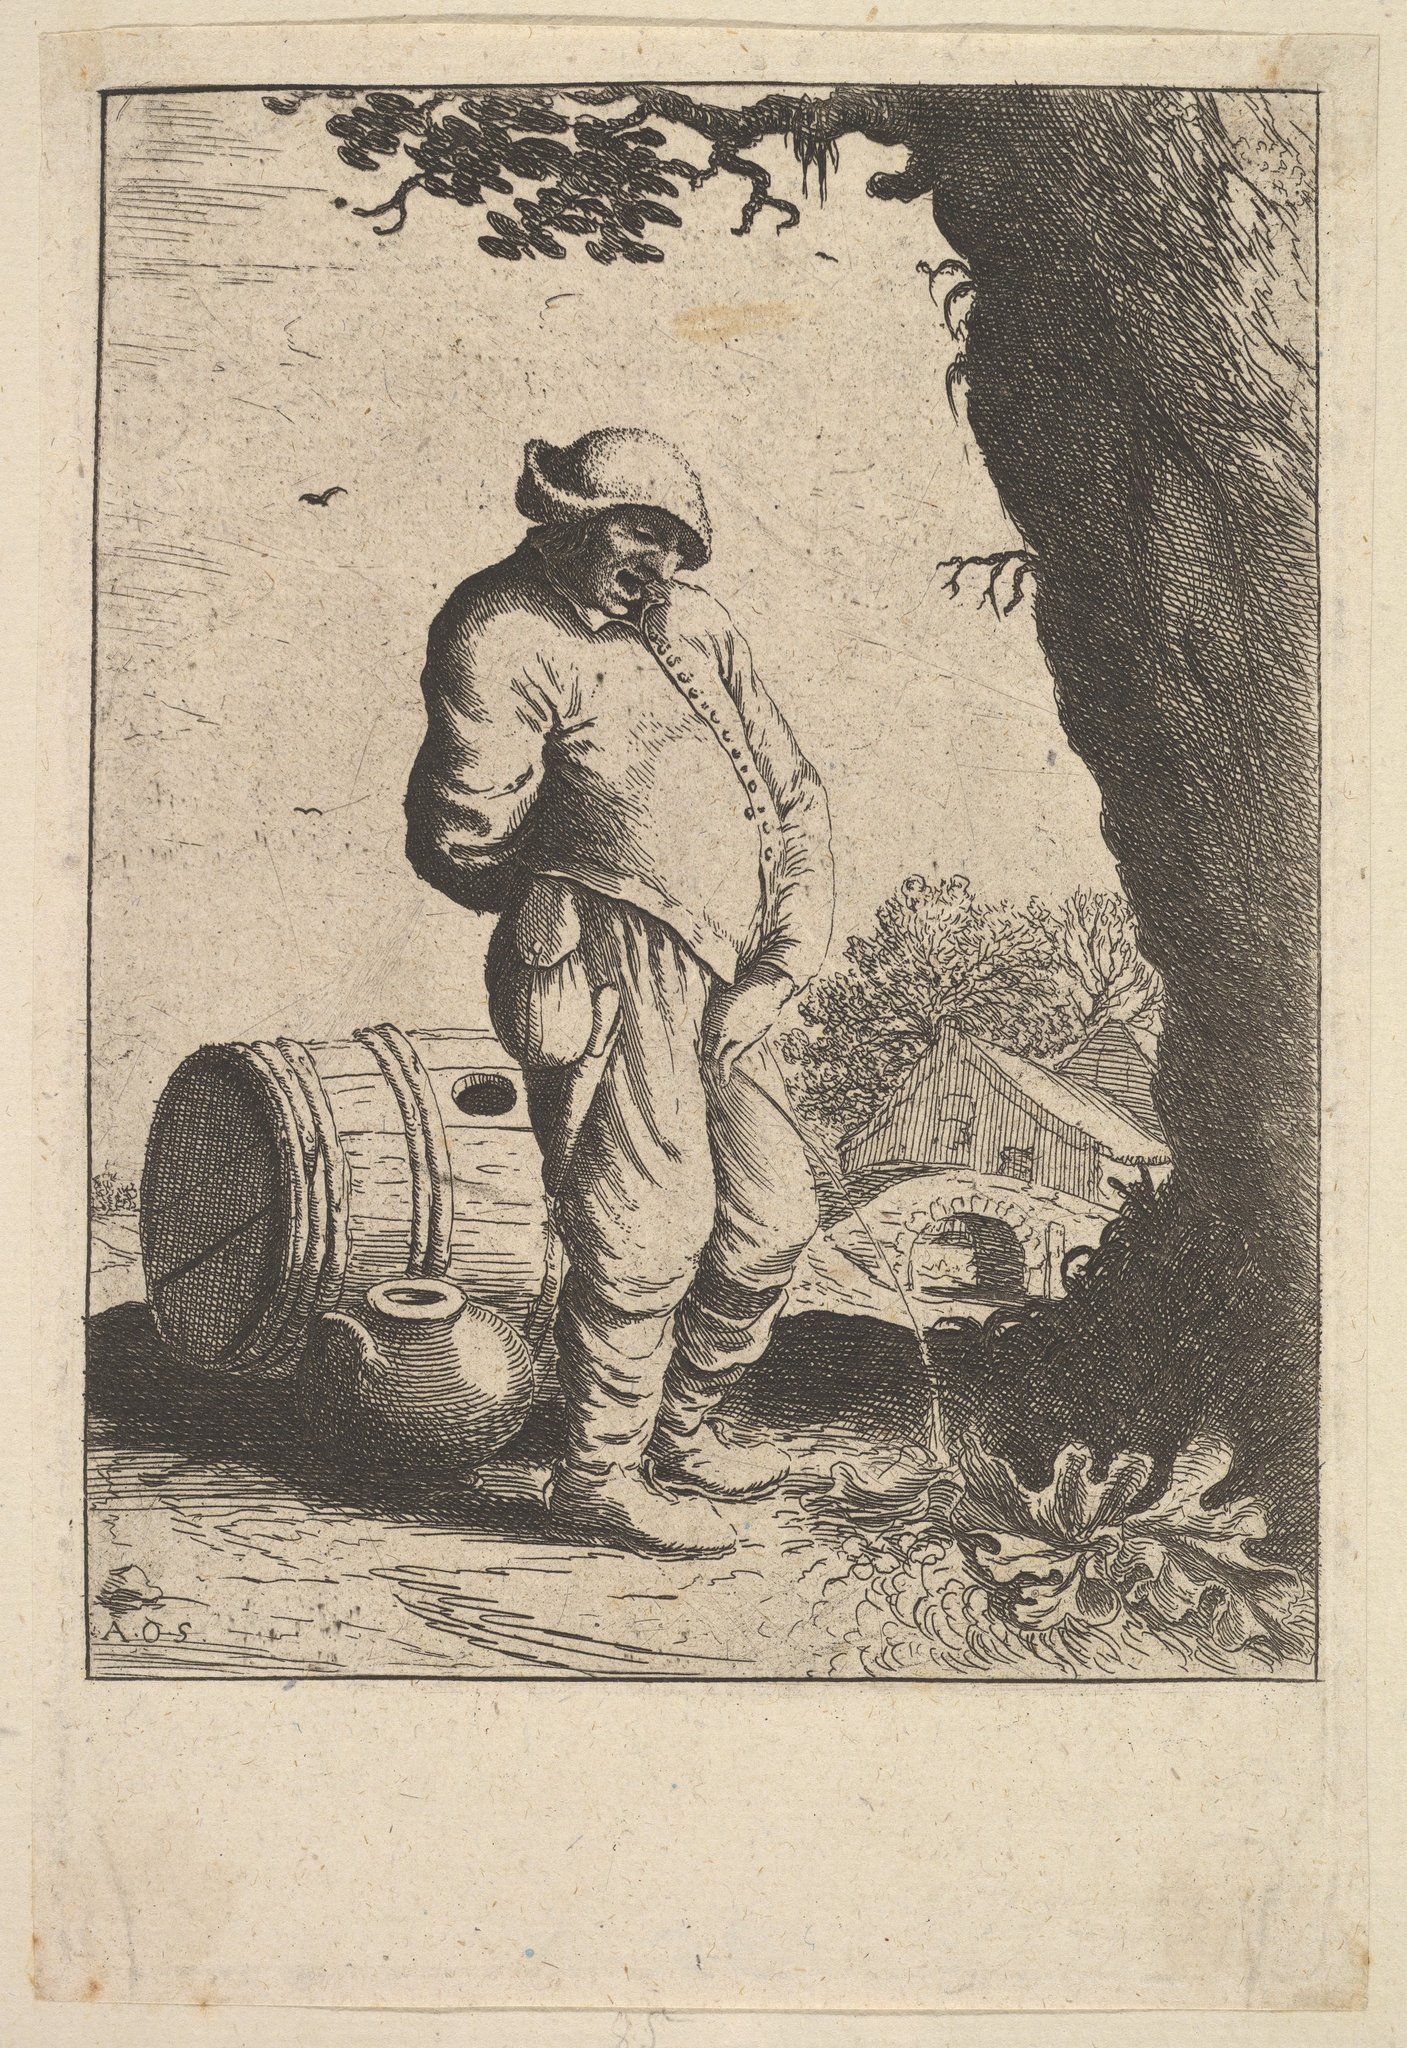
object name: print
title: The Pissing Man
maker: adriaen van ostade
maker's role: artist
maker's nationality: dutch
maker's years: 1610-1685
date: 1610-1685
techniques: etching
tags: men,trees